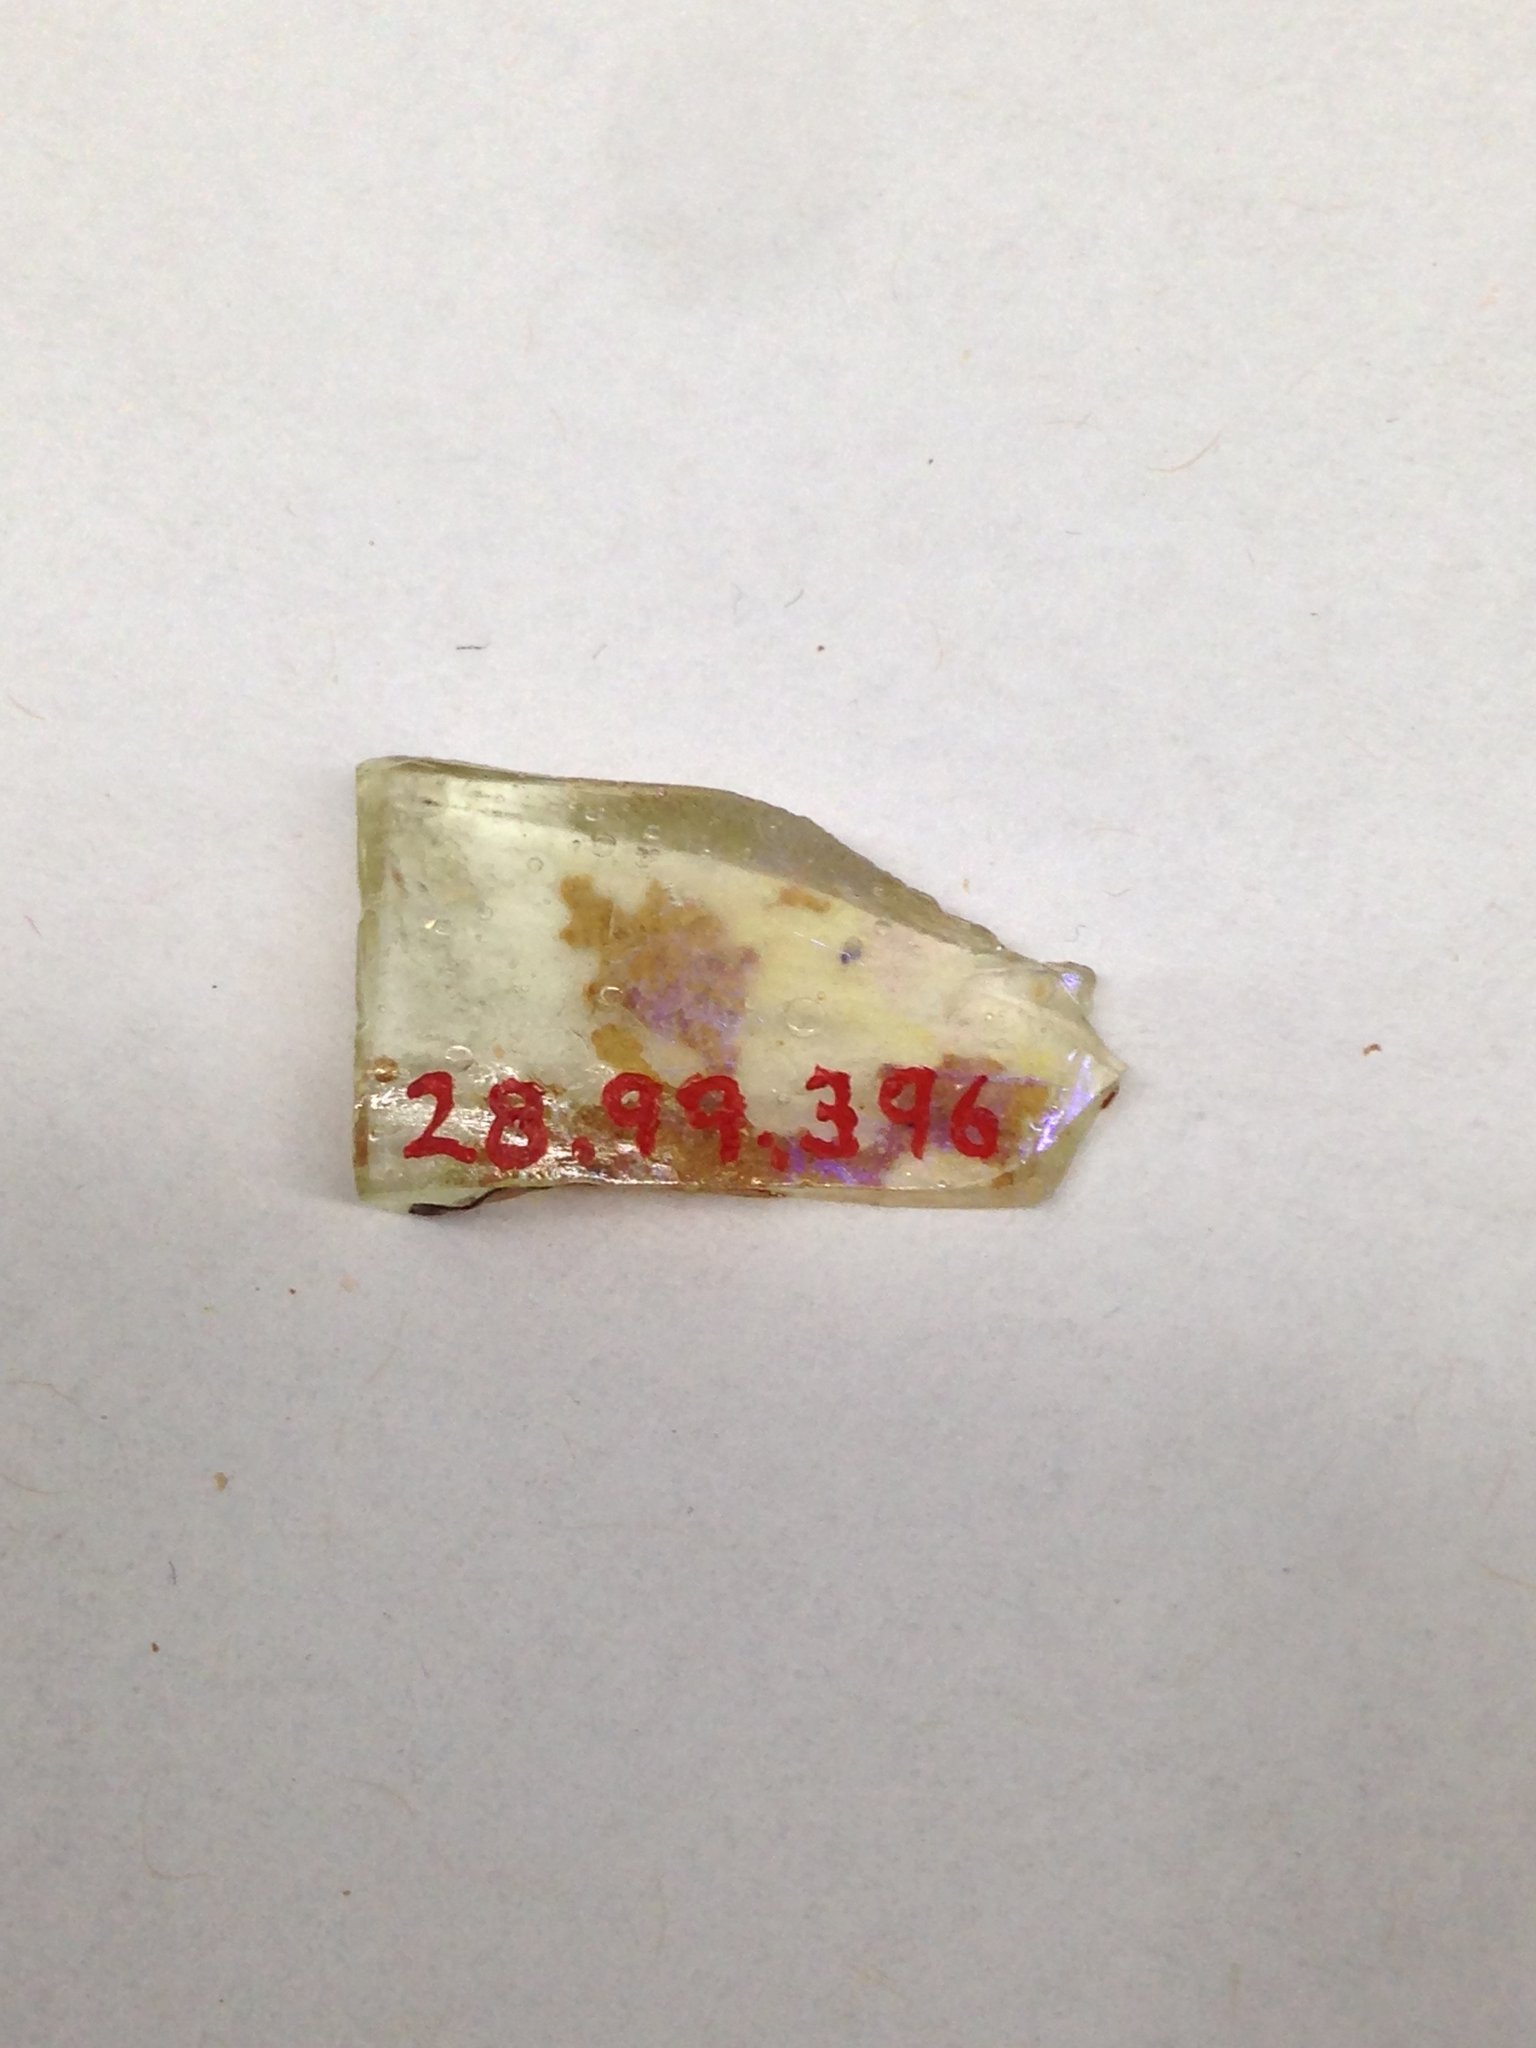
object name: fragment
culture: european or middle eastern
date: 1150-1250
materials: ceramic, glass